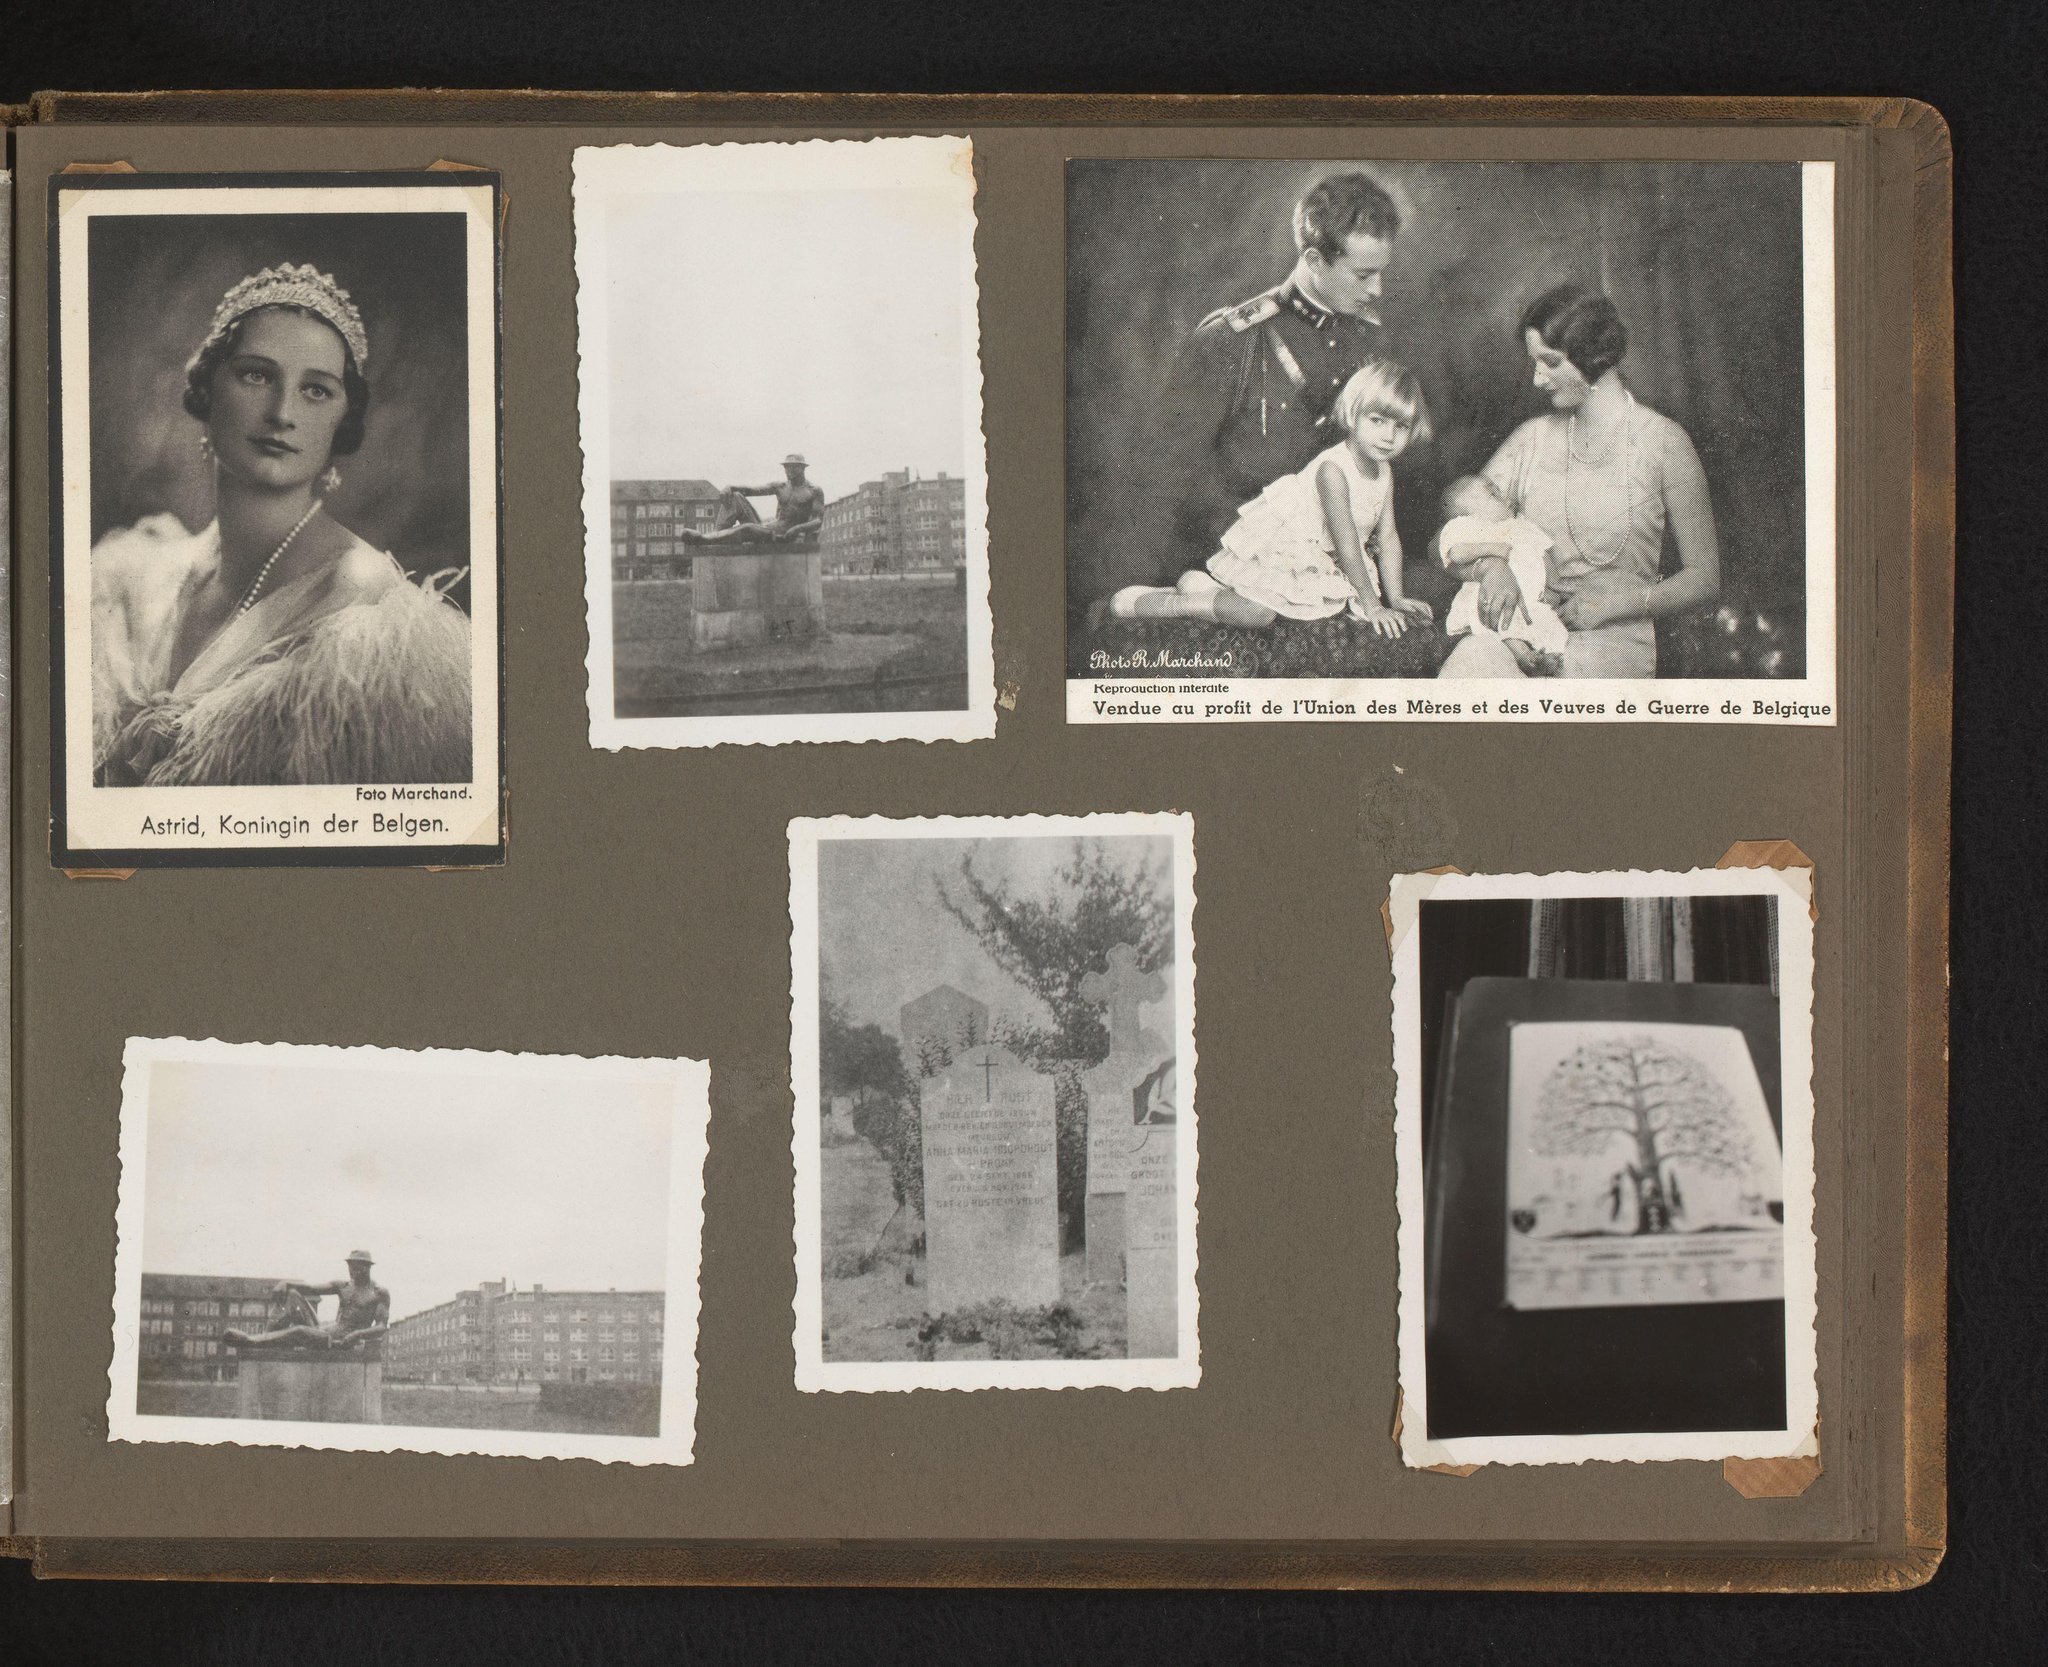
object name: photomechanical print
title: Diverse afbeeldingen waaronder portretten van koningin Astrid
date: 1900-1950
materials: paper, photographic support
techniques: gelatin silver print, rotogravure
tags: brussels, parents with their children, family of a ruler, and court, historical persons, grave, tomb, monument, statue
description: Portret van Koningin Astrid en fotoreproductie van een familieportret van koningin Astrid met koning Leopold III en prinses Josepine Charlotte en koning Boudewijn I. Ook bevat de pagina twee foto's van een monument, een foto van het graf van Anna Maria Noordhout-Pronk en een foto van een stamboom. Deze pagina maakt deel uit van een album.